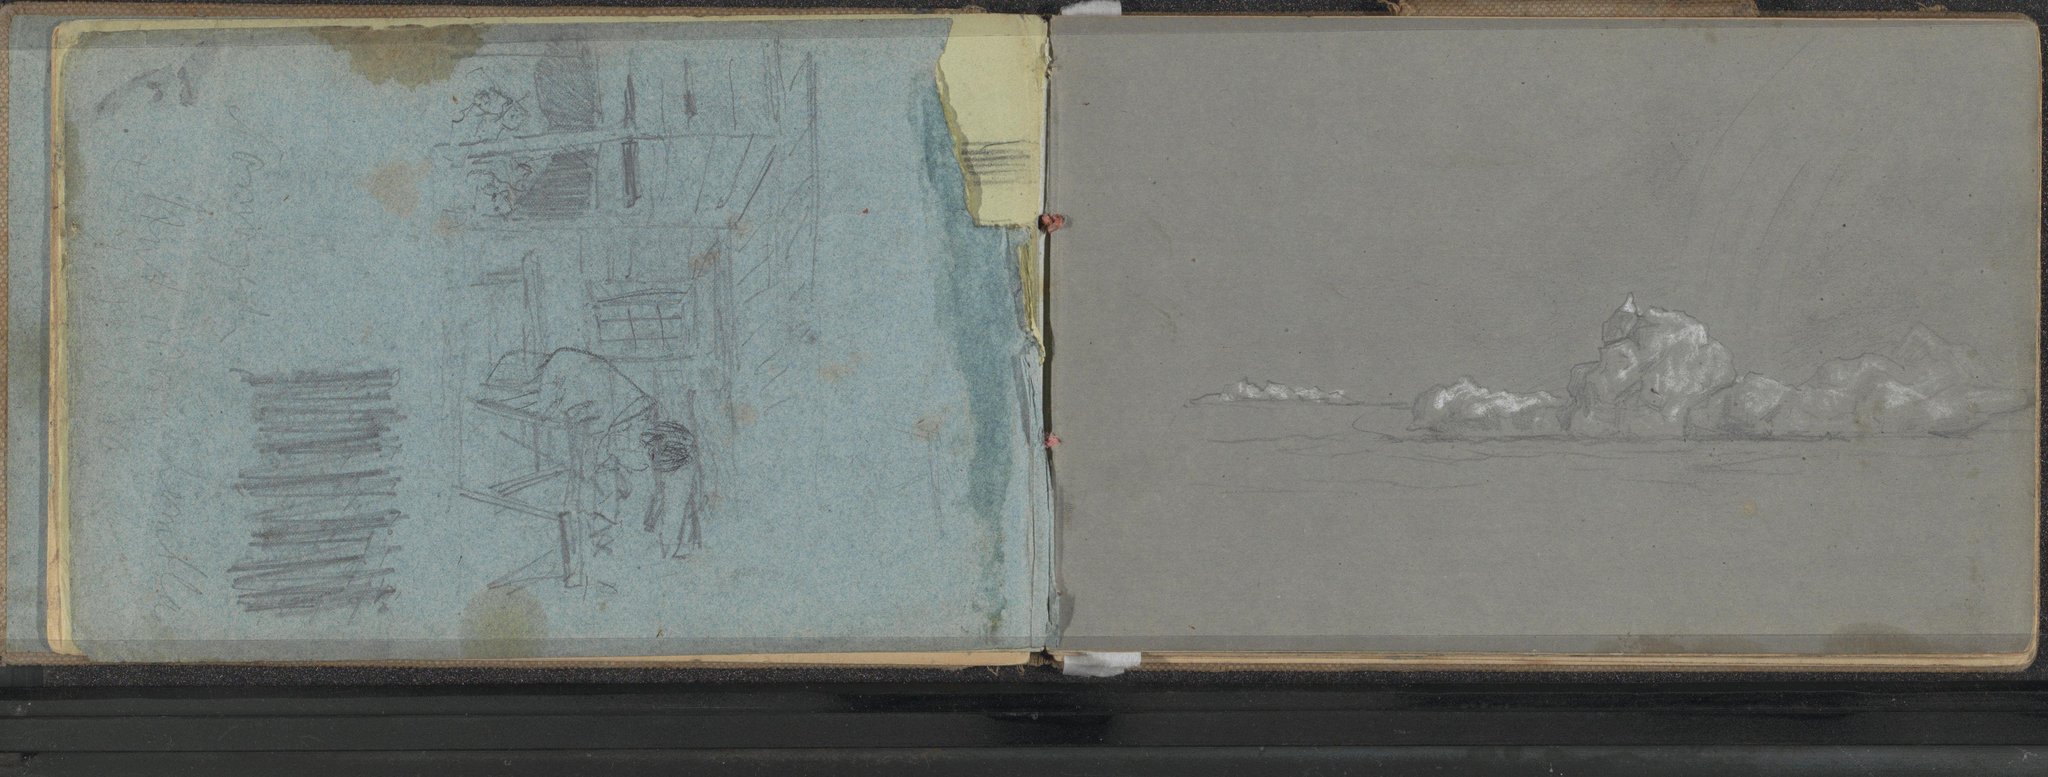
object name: sketchbook leaf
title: Samojeed aan een tafel in houten huis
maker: louis apol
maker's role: draughtsman, painter, print maker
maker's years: 1850-1936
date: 1880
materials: paper, pencil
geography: novaya zemlya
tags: table, interior of the house, sitting on an elevation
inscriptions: annotation: ‘Samojeden/ Hut Nova Zembla/ [...]’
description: Blad 7 verso uit een schetsboek met 35 bladen betekend tijdens de expeditie naar Nova Zembla in 1880.